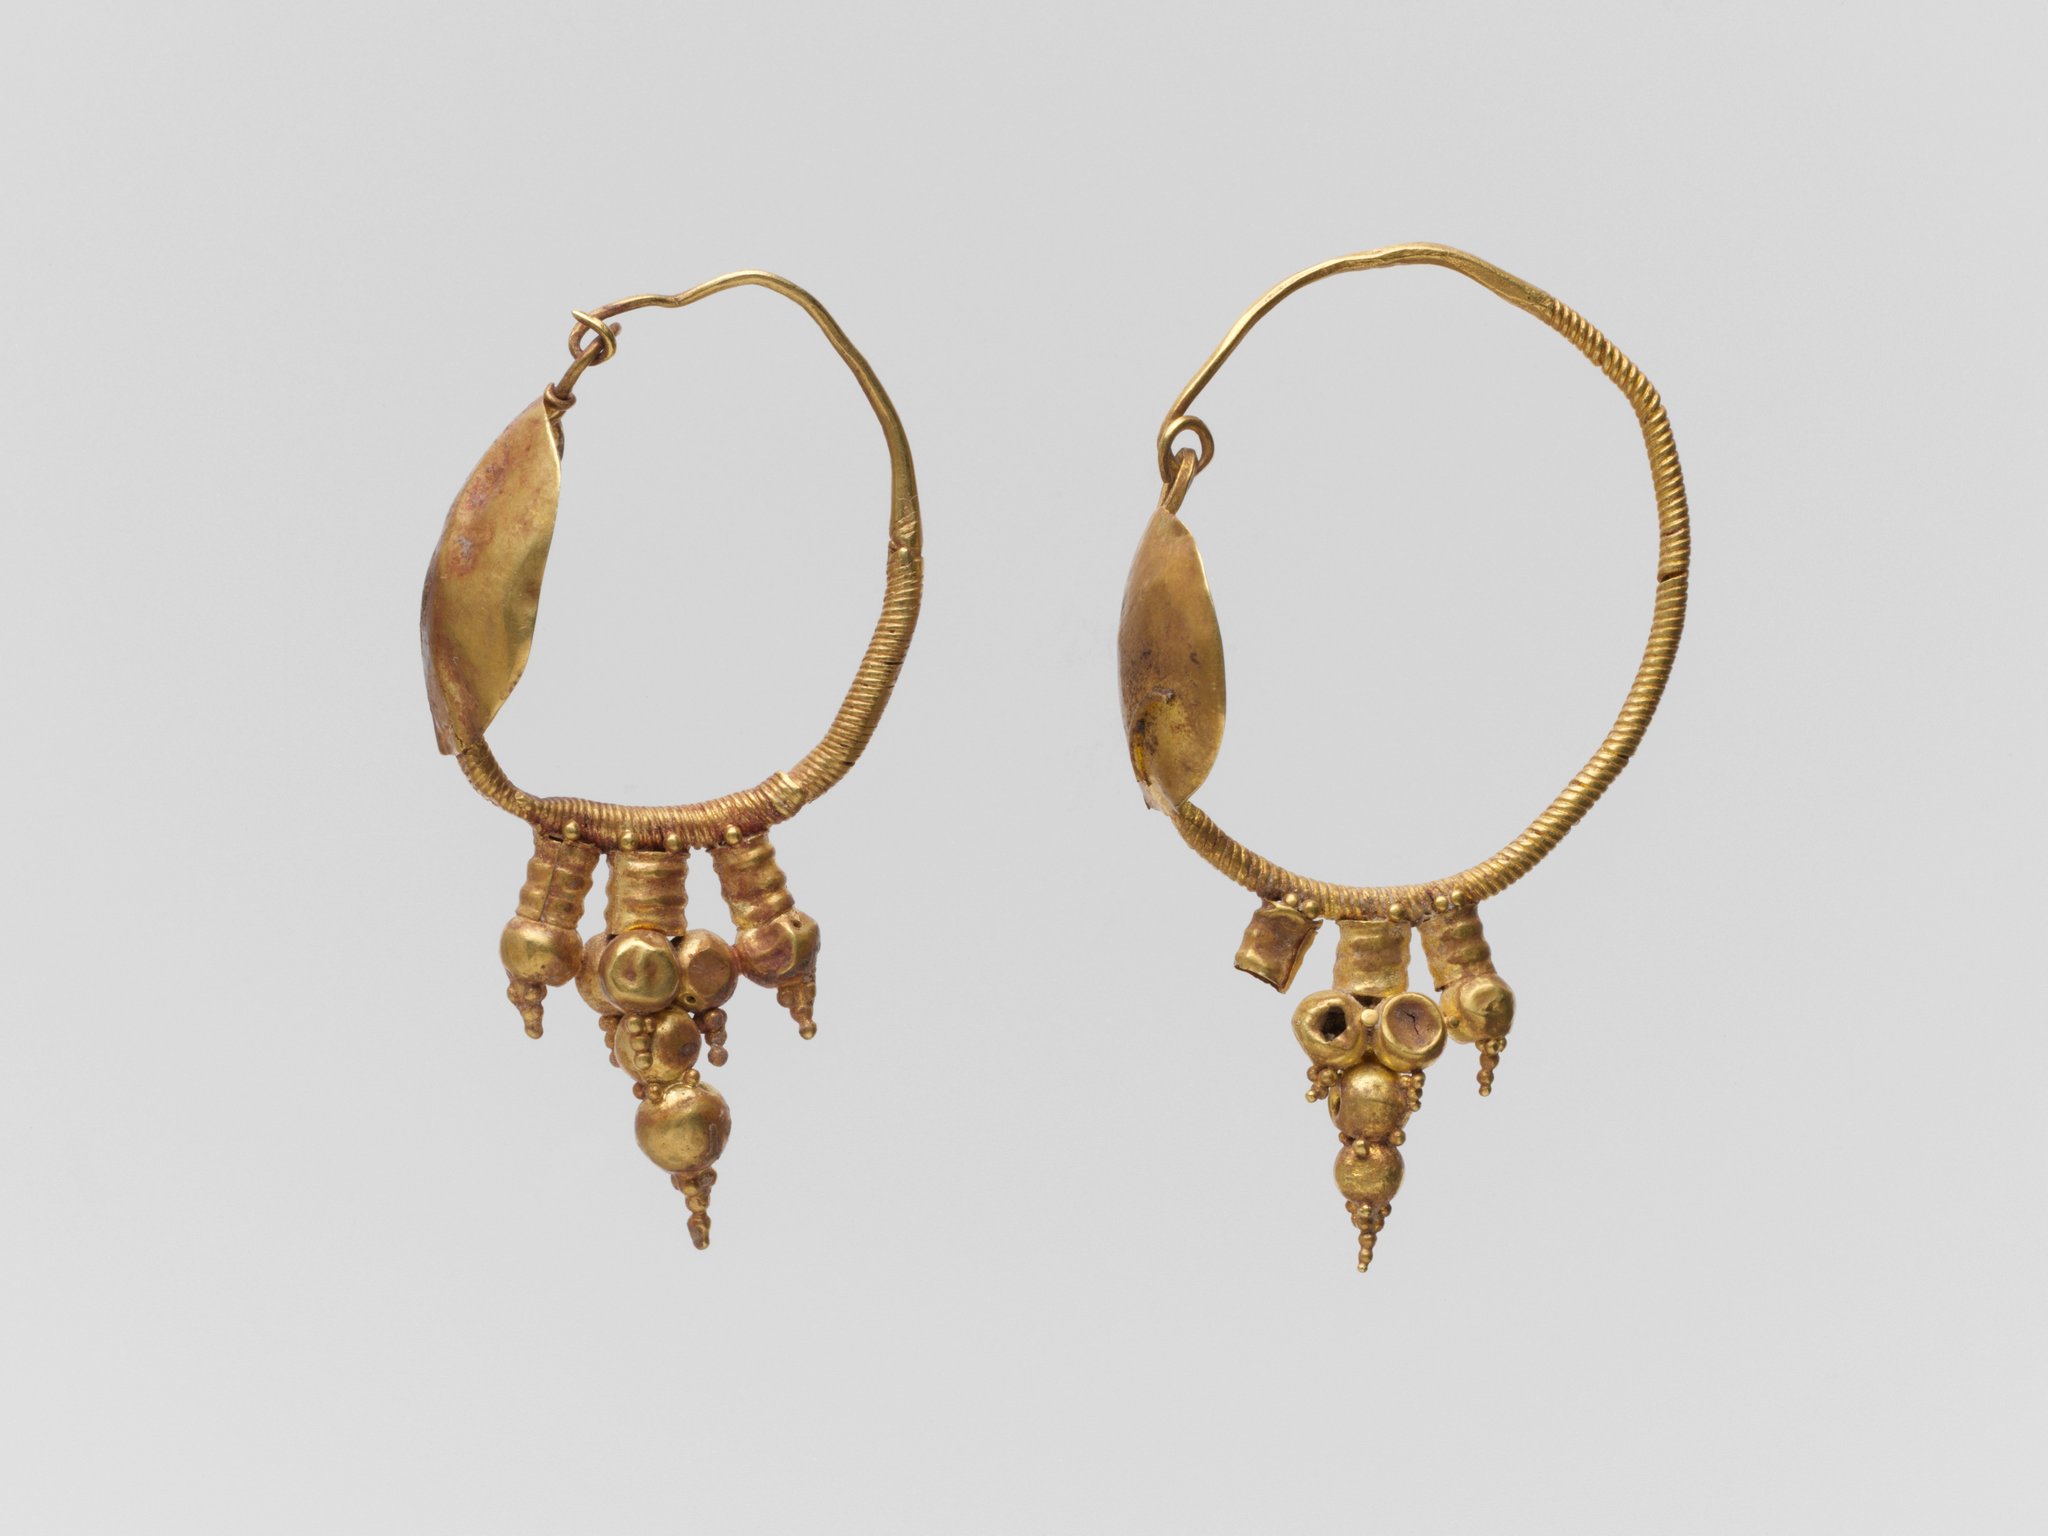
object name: earring with disc and pyramid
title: Pair of gold earrings with disk and pendant clustered spheres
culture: roman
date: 101-300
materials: gold